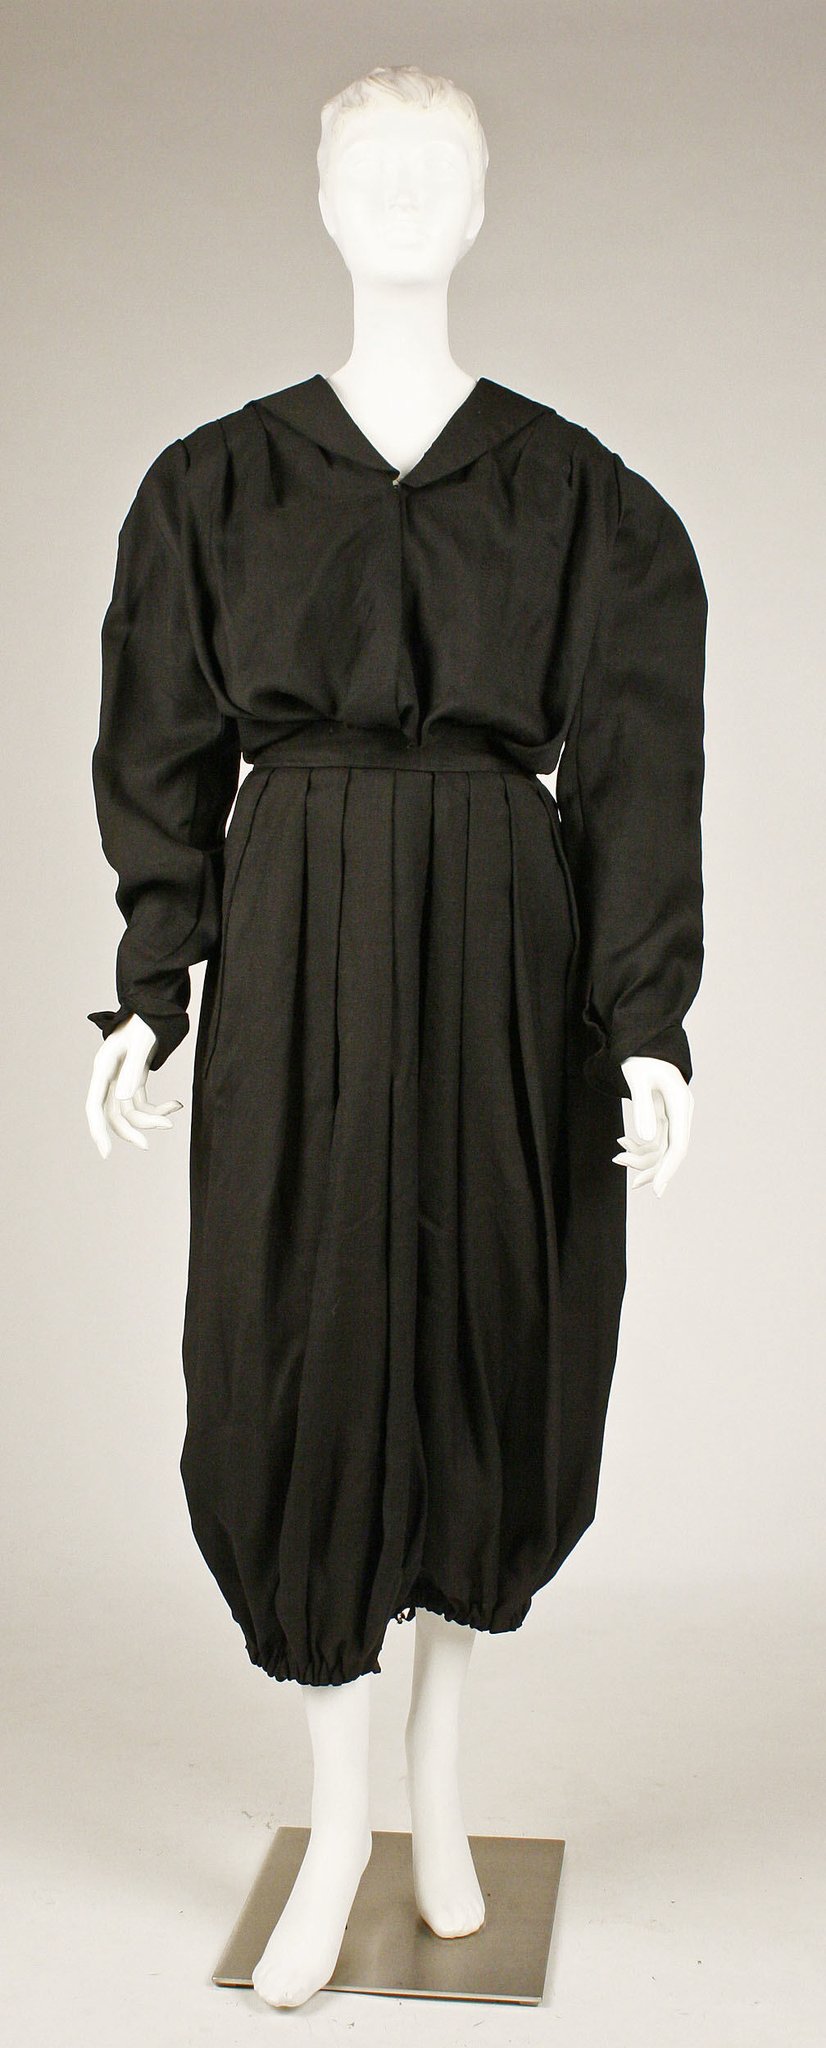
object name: gym suit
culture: american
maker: r.h. stearns company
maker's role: department store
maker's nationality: american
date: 1898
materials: wool